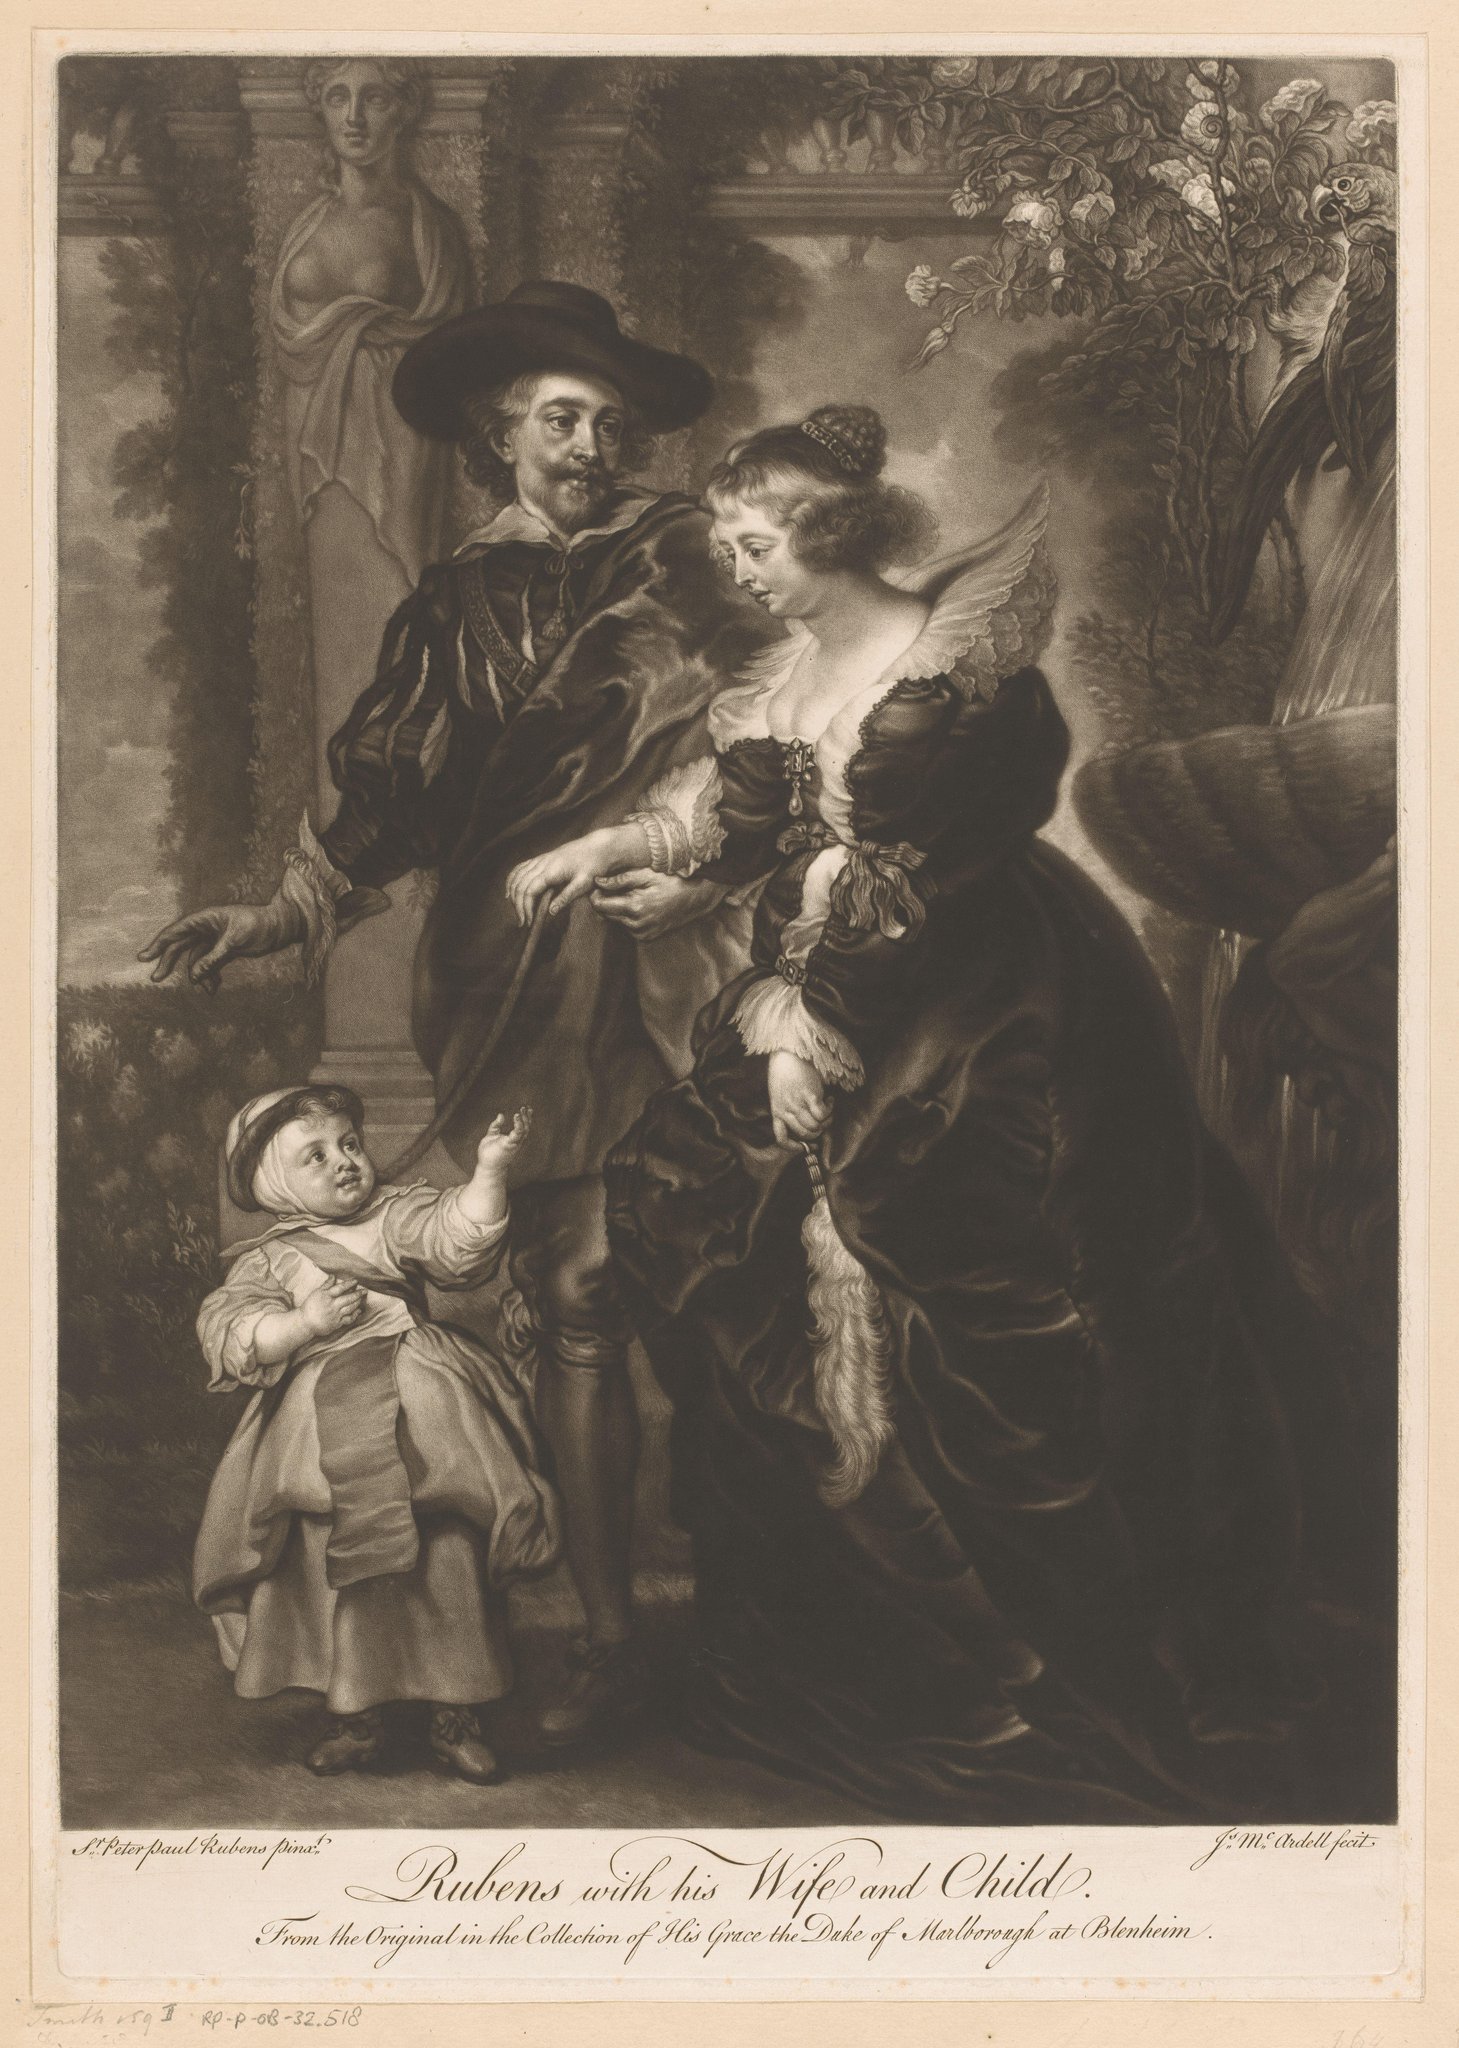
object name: print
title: Portret van Peter Paul Rubens, Hélène Fourment en hun zoon Frans of Pieter Paul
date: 1745-1765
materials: paper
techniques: mezzotint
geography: london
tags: antwerp, painter, print maker, draughtsman, peter paul rubens, mother and son(s) (family group), historical persons, father and son(s) (family group), statues, sculptures in garden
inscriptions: collector's mark: Lugt 240